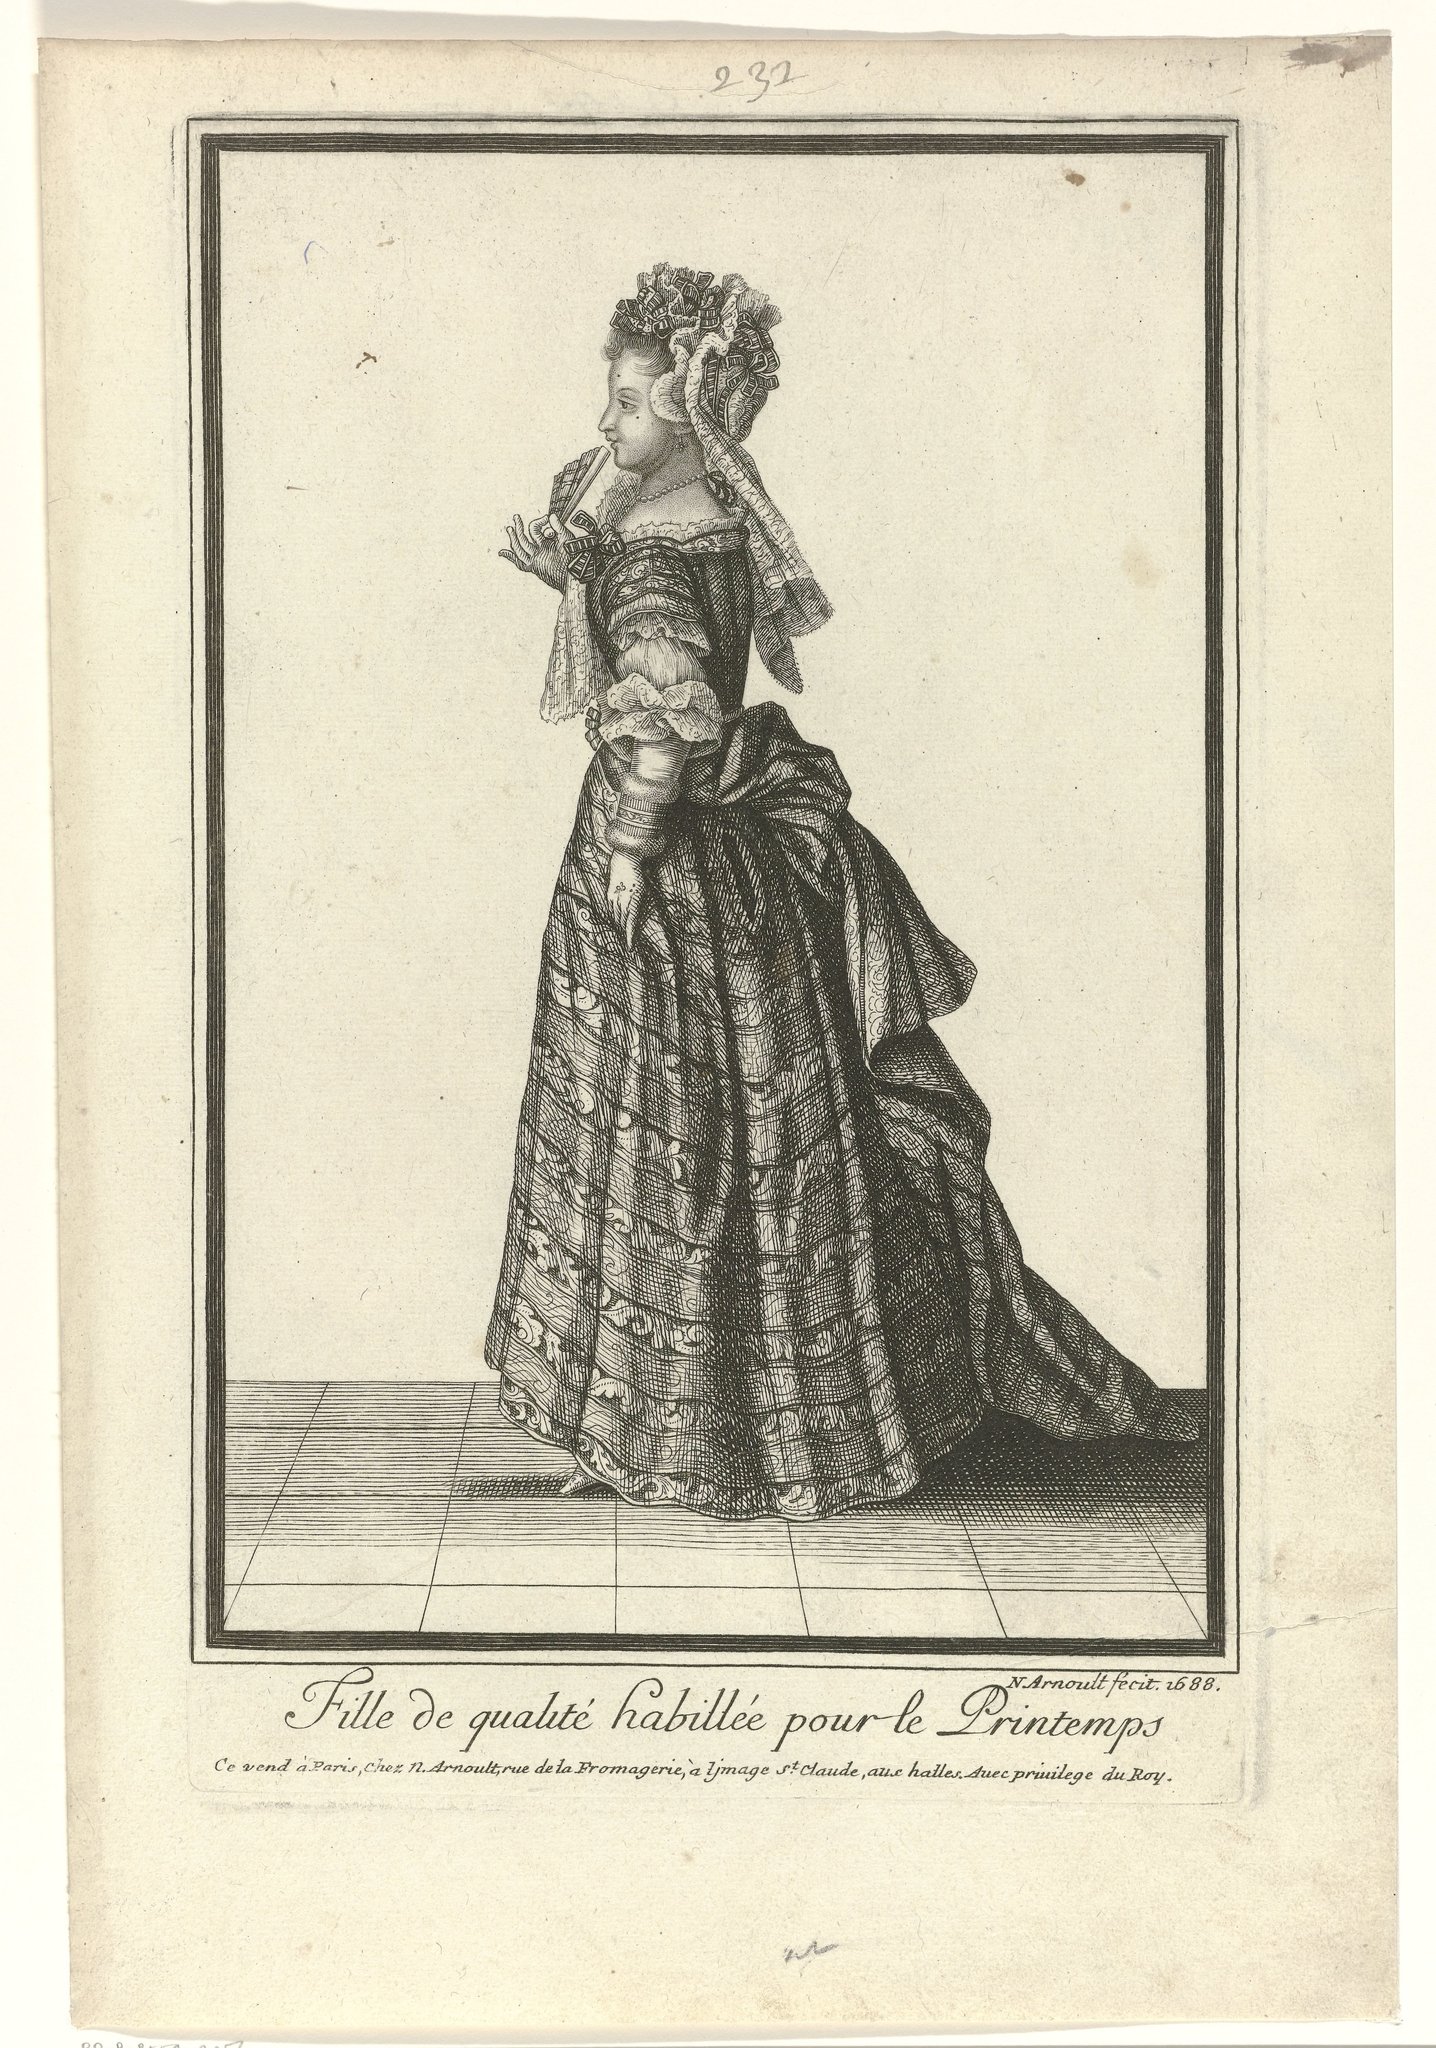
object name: print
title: Fille de qualité habillée pour le Printemps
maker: nicolas arnoult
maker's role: print maker, publisher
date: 1688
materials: paper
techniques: etching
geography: paris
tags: ear-rings (+ women's clothes), head-gear: cap (+ women's clothes), fashion plates, clothes, costume (+ women's clothes), skirt (+ women's clothes), gloves, mittens, etc. (+ women's clothes), fan (+ women's clothes), dress, gown: manteau (+ women's clothes), pearl; pearl necklace (+ women's clothes)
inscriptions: title: ‘Fille de qualité habillée pour le Printemps’, address: ‘Ce vend à Paris, chez N.Arnoult, rue de la Fromagerie, à ljmage St.Claude, aux halles. Avec privilege du Roy.’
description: Vooraanstaande jonge vrouw, lopend naar links, gekleed in een kostuum voor de lente. Zij draagt een manteau met sleep en een gestreepte rok met steekzakken. Op het hoofd een muts versierd met strikjes van gestreept lint en afhangende slippen. In het gezicht twee mouches. Accessoires: oorbel, kralencollier (parelcollier), waaier en handschoenen. De prent maakt deel uit van een reeks van 82 kostuumprenten, uitgegeven door Nicolas Arnoult, Parijs, 1682-1690.